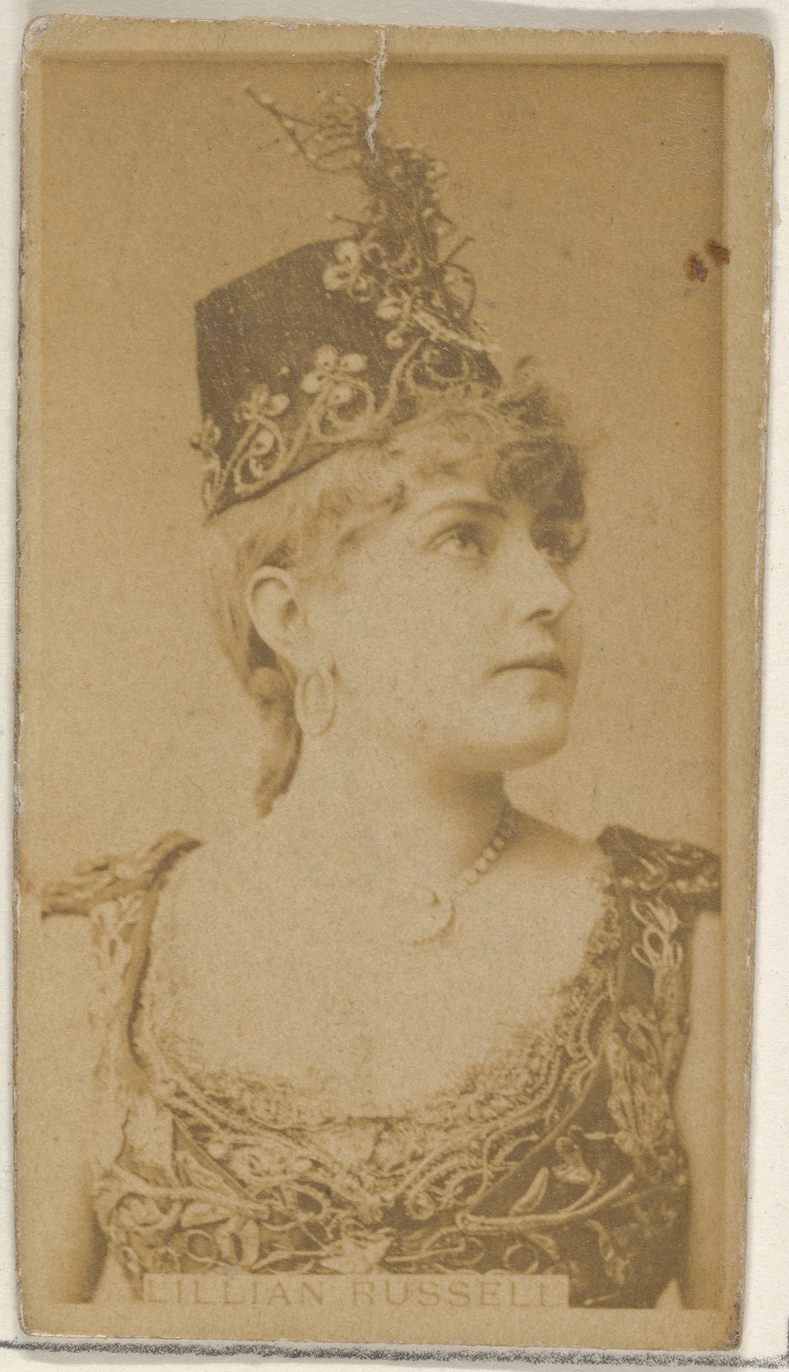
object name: photograph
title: Lillian Russell, from the Actors and Actresses series (N45, Type 8) for Virginia Brights Cigarettes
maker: allen & ginter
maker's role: publisher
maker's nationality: american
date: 1888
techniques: albumen silver print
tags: portraits,women,actresses